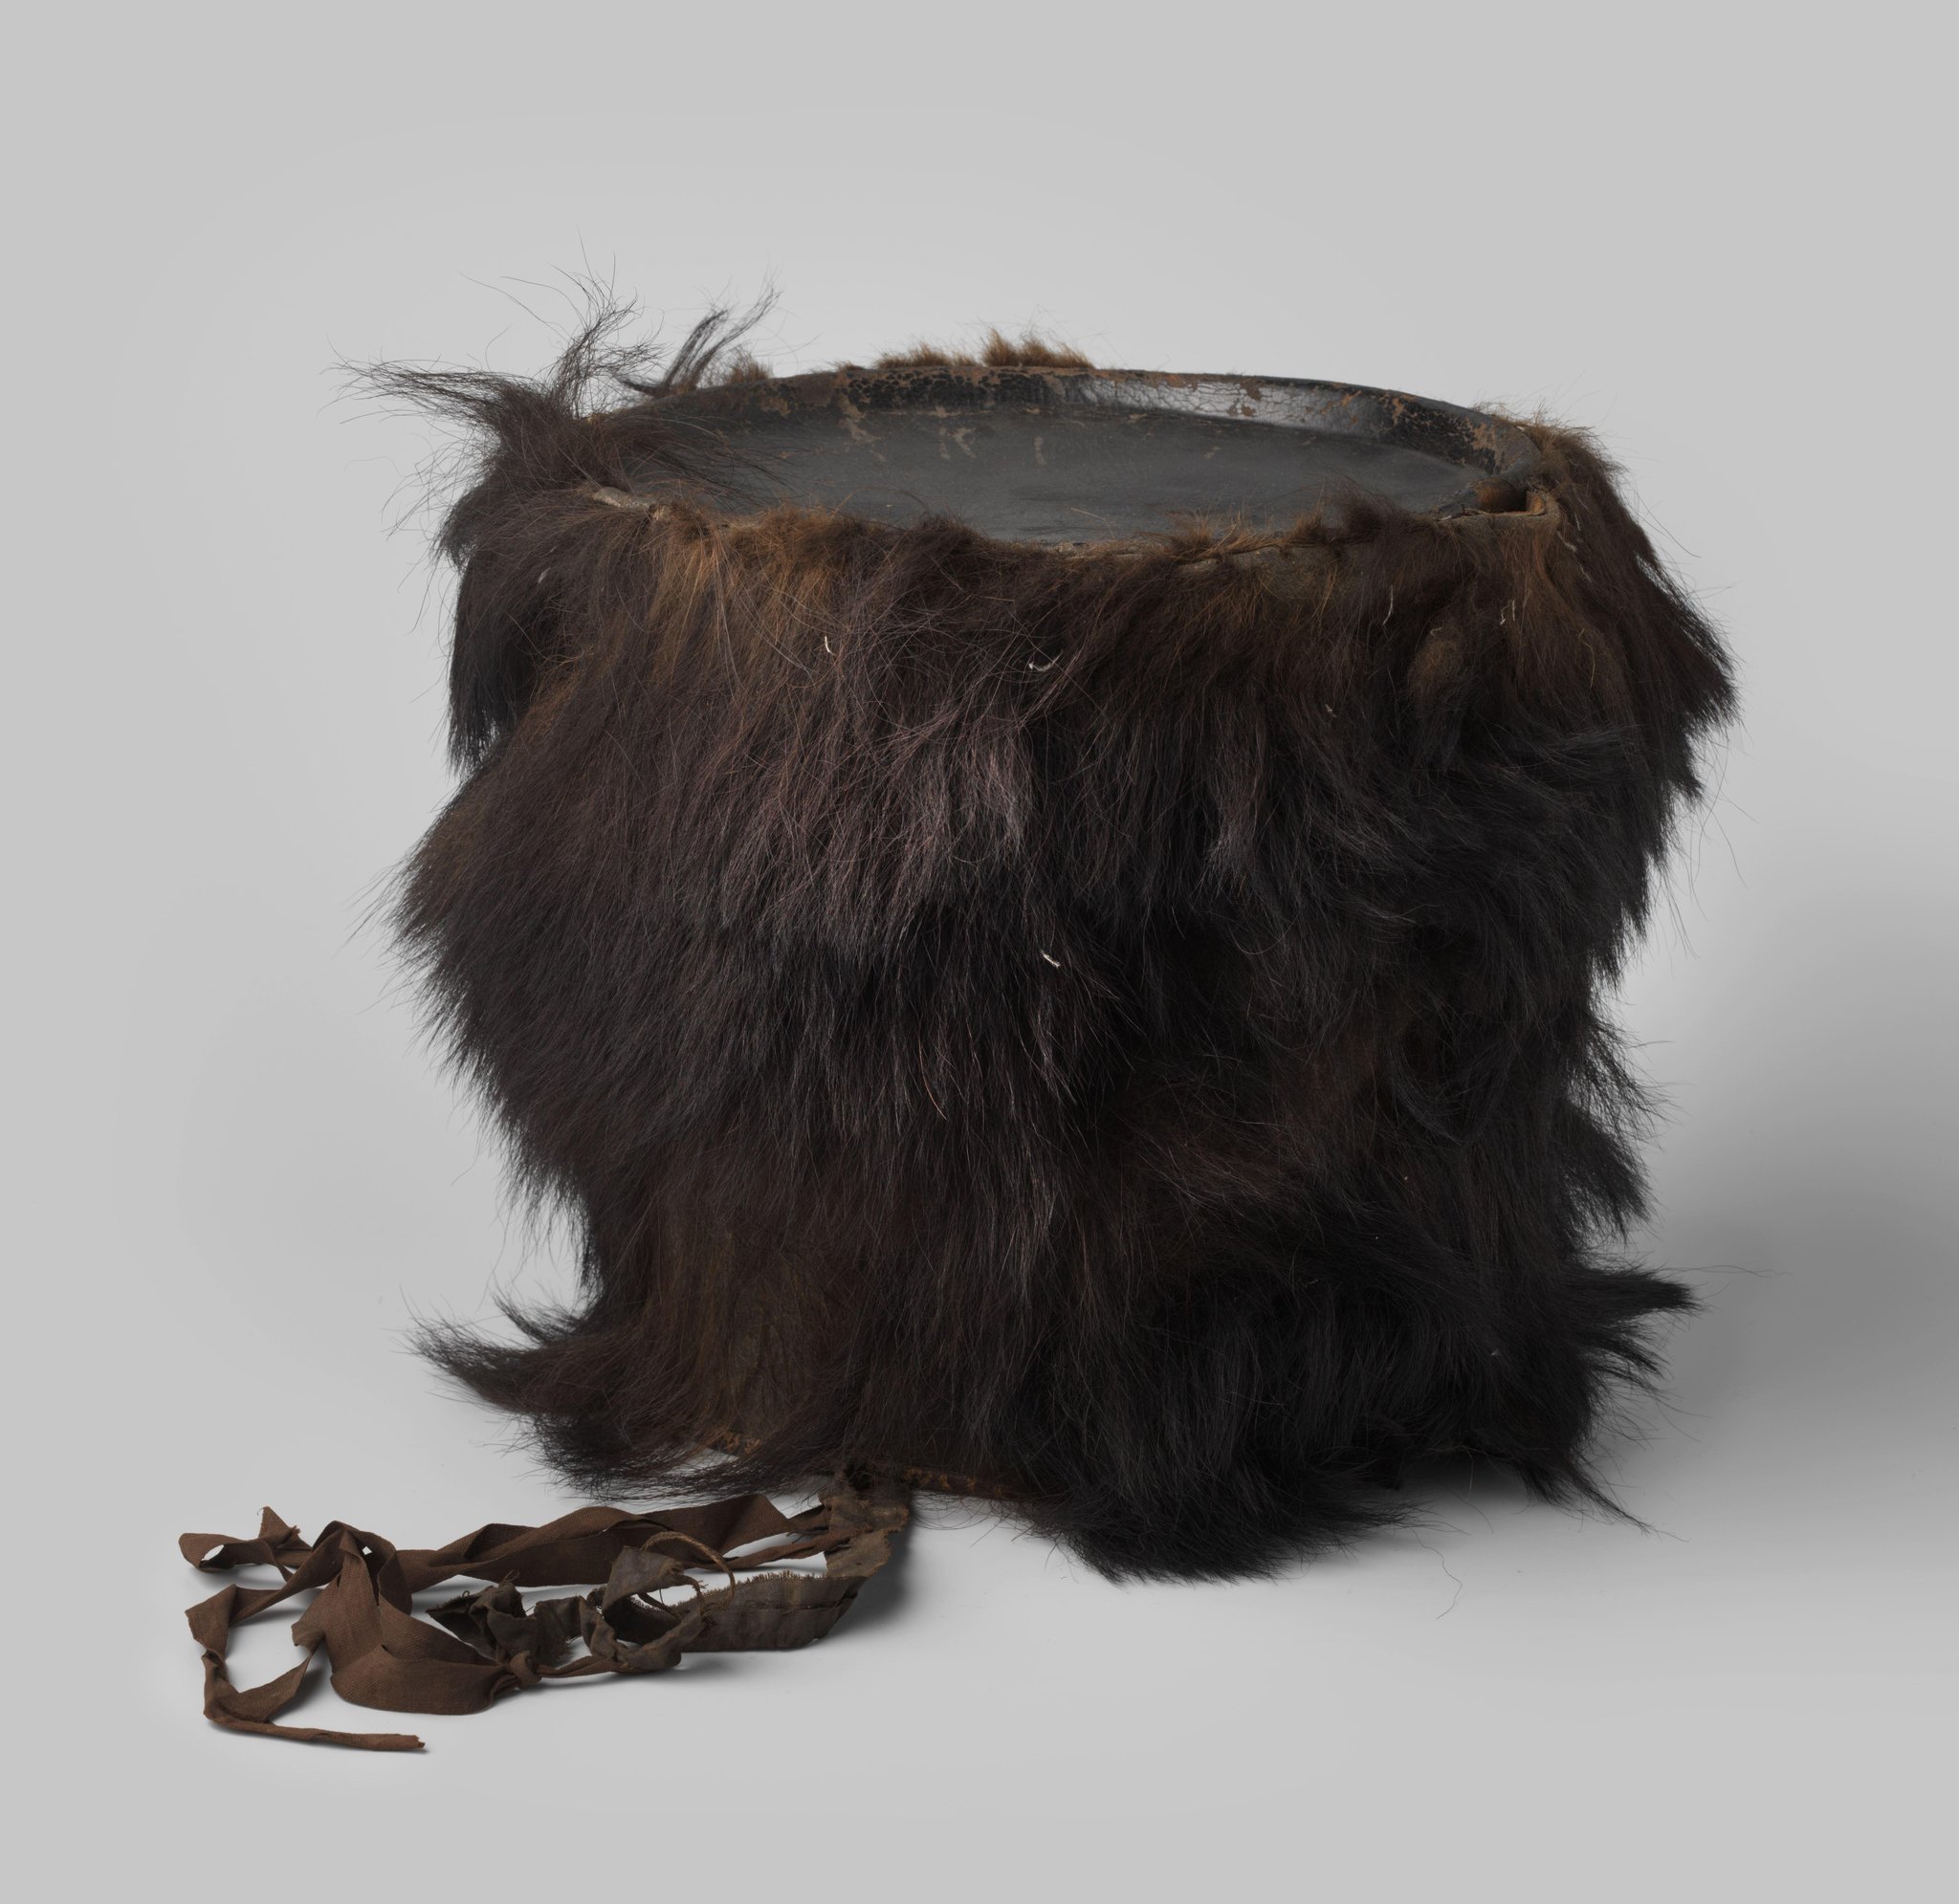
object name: busby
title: Kolbak van sappeur of tambour-maitre, M. 1823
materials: copper, fur, leather, linen, paper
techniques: forging, stitching, tanning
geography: the hague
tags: netherlands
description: Hoofddeksel van deels gesleten zwart berenhuid (imitatie?). Zwart leren bodem, waarin sleuf voor pompon. Binnenwerk bruin leren zweetband, waaraan zwart linnen voering. Tevens een halve zwarte lakleren kinriem met zwarte gesp. Op bodem blauw etiket met gouden opdruk van rijkswapen en Willem Pauwels en zoon hoedenfabrikanten' s Hage Westeinde (rest onleesbaar).